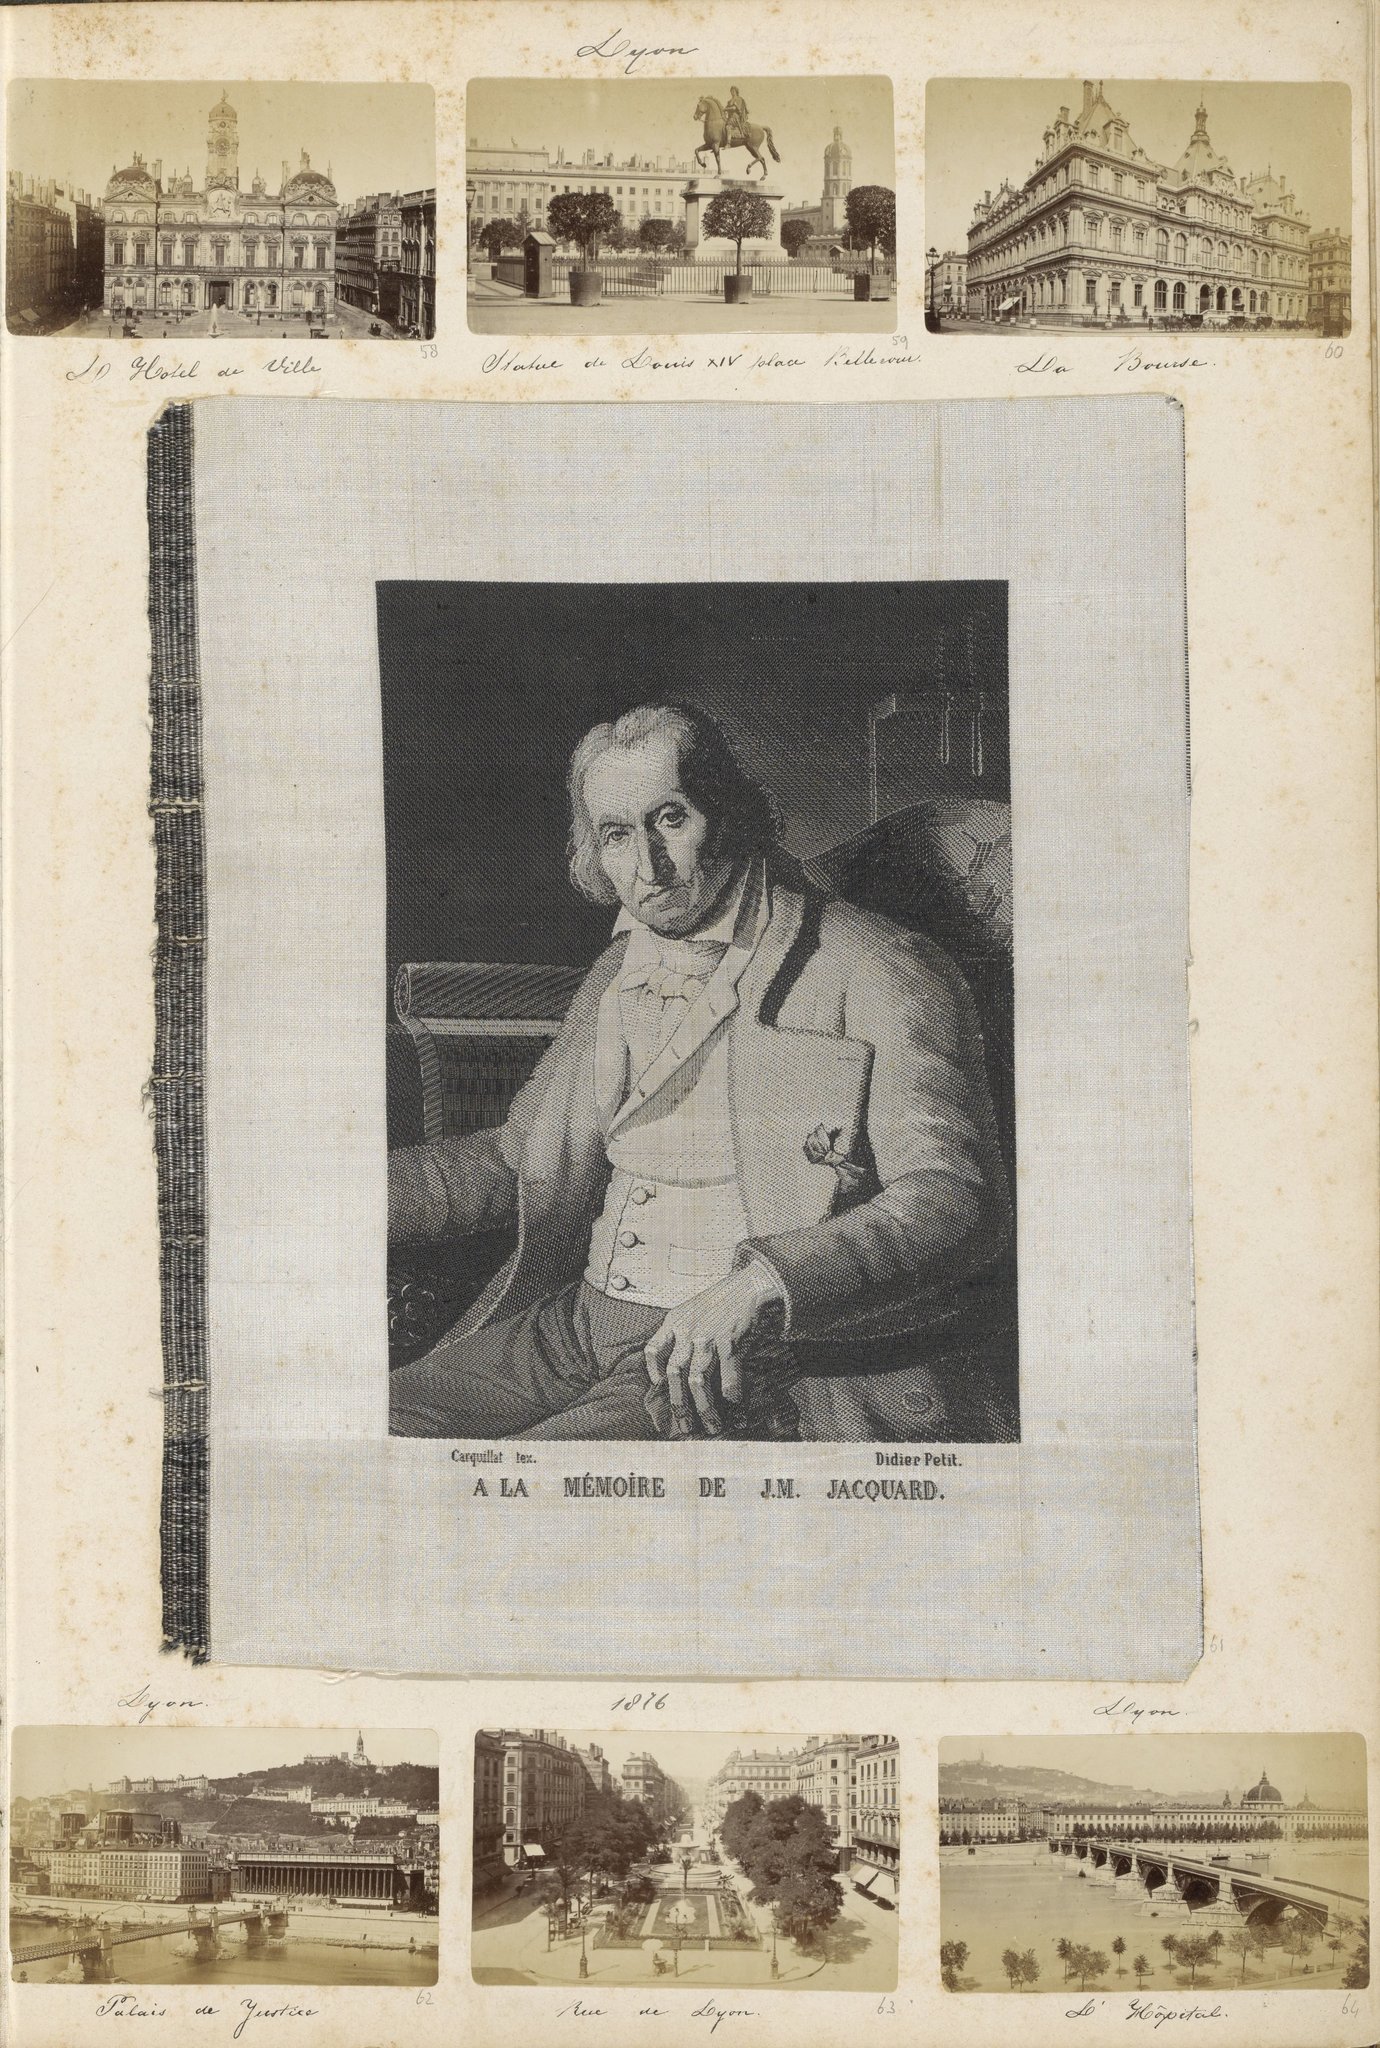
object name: photograph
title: Exterieur van het stadhuis van Lyon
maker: Anonymous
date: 1870-1880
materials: paper, photographic support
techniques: albumen print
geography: lyon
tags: townhall, lyon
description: Onderdeel van Fotoalbum van Robert Daniel Crommelin (1841-1907).